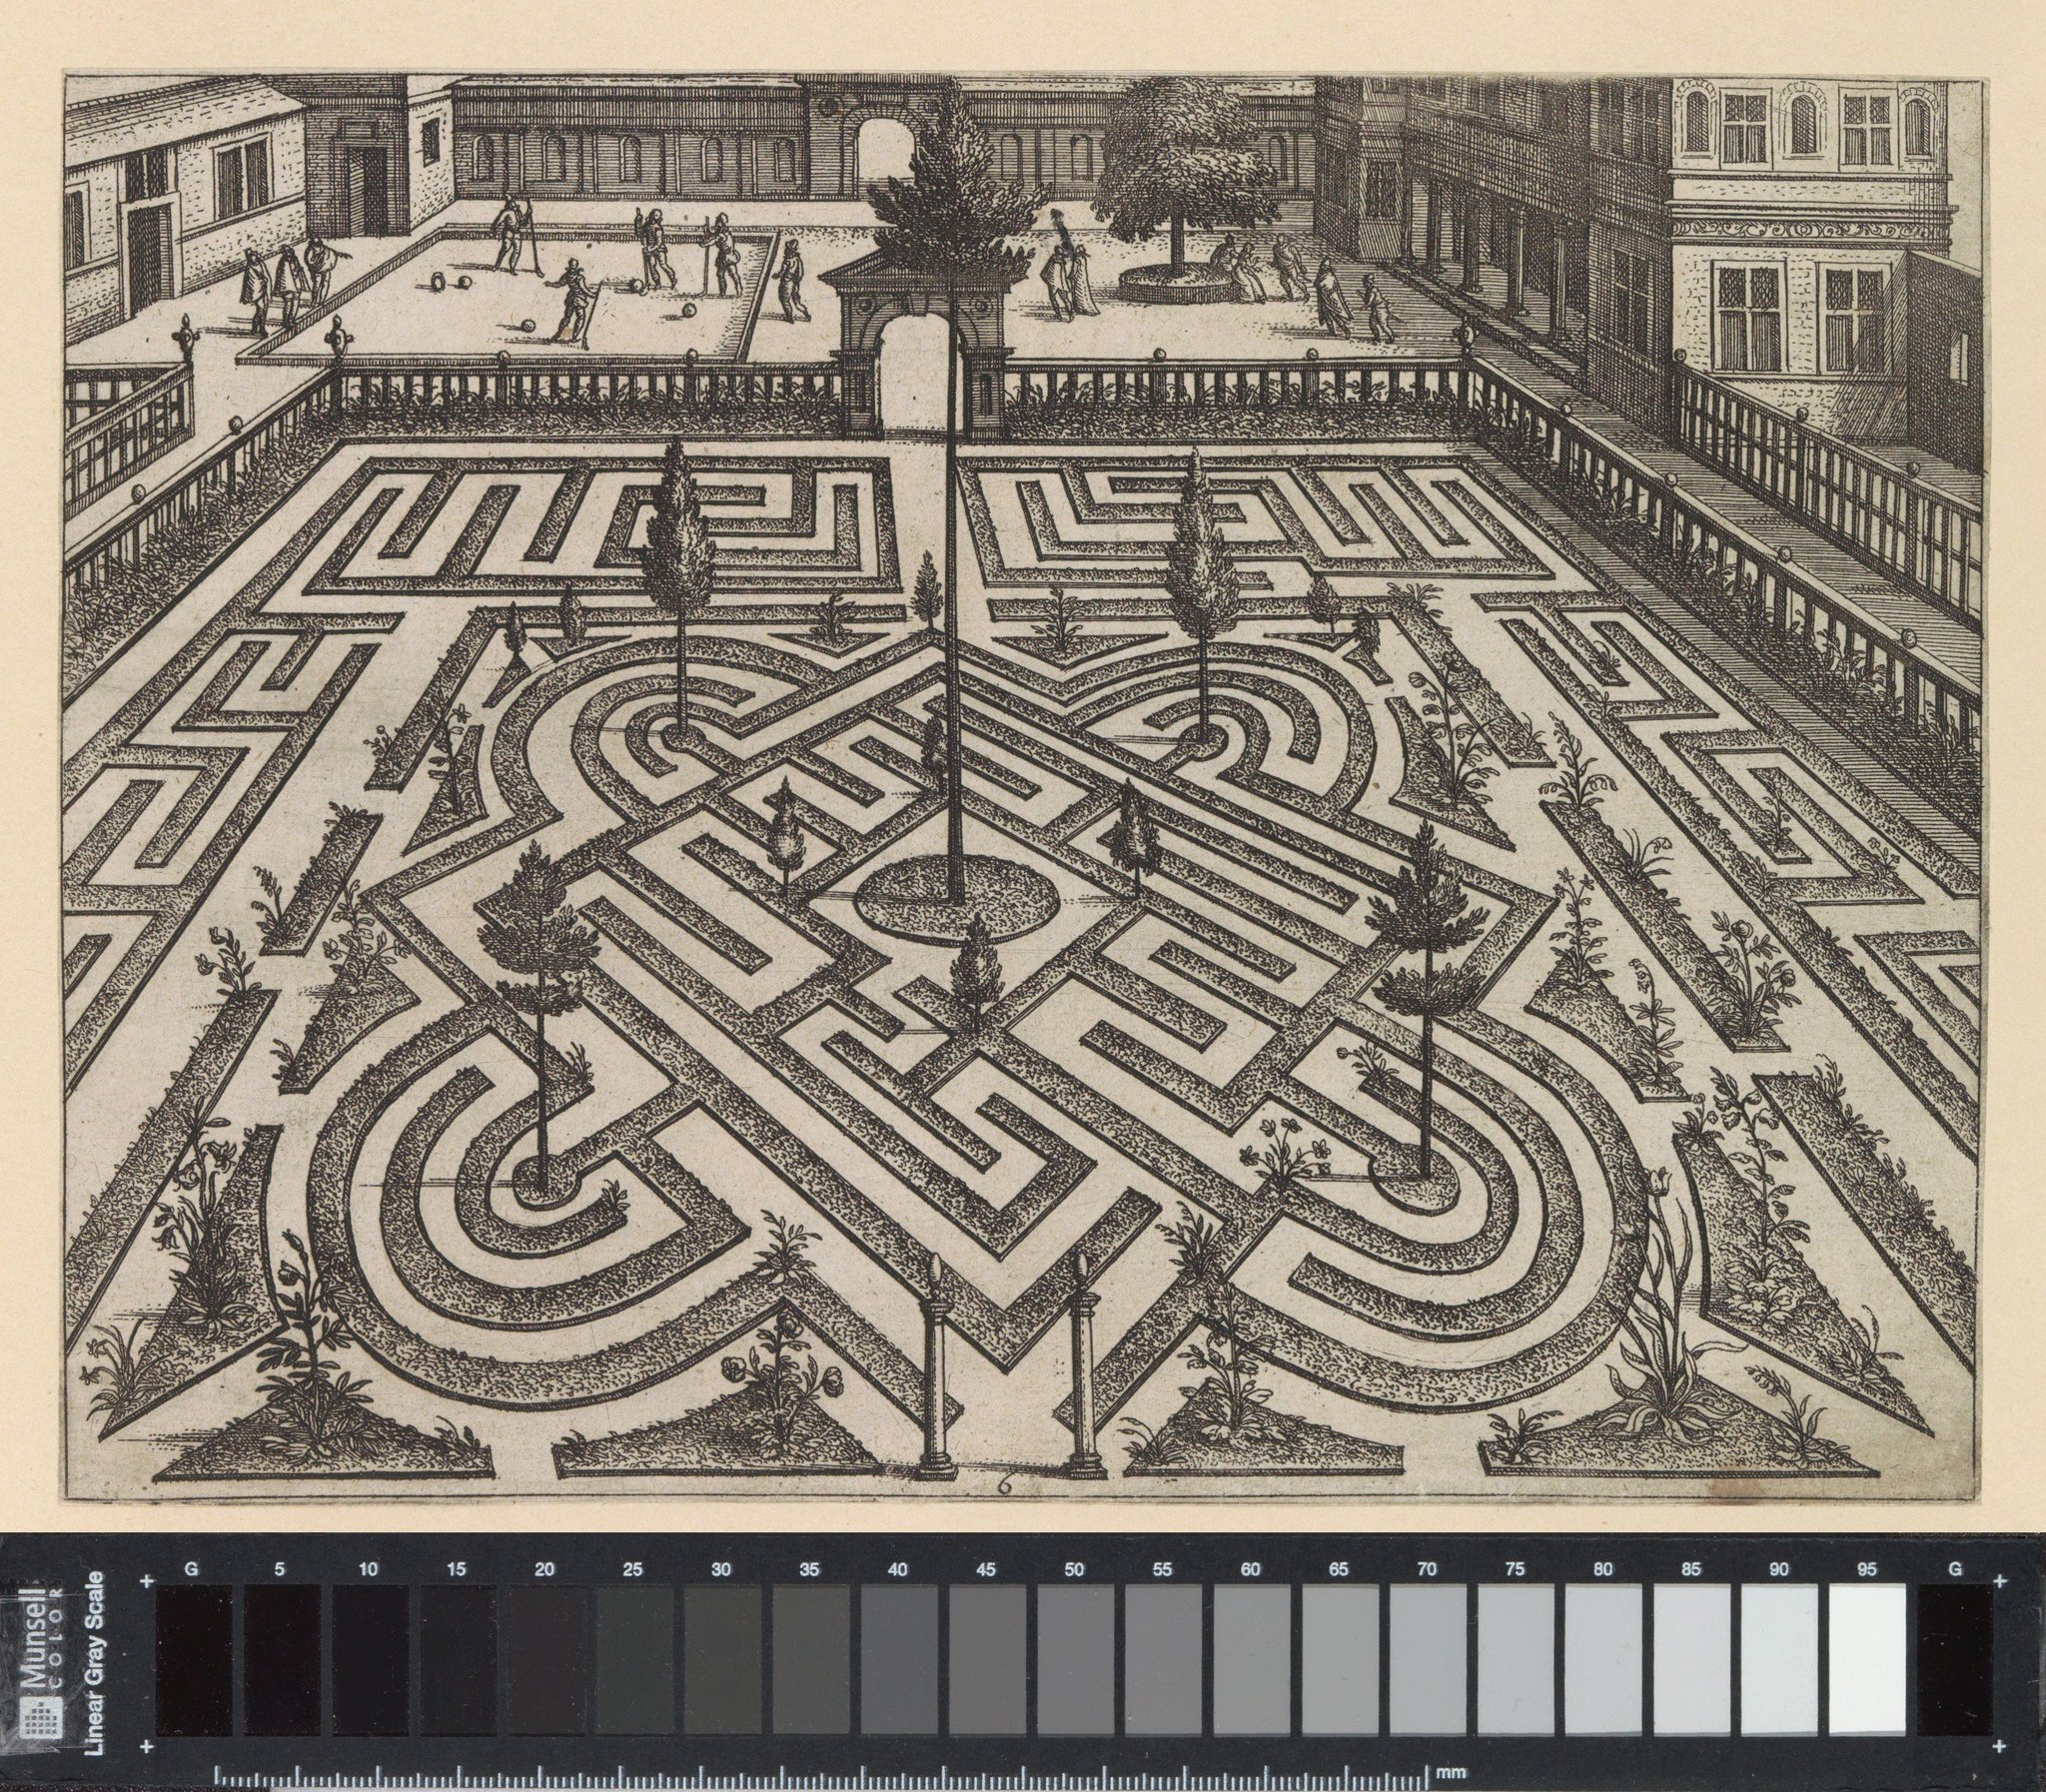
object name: ornament print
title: Hortorum Viridariorumque elegantes et multiplicis formae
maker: Anonymous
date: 1587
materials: paper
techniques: etching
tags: garden, labyrinth, maze ~ garden, 'kolf' (ball game)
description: Tuin met een parterre gevormd door lage perkjes in een geometrisch patroon, bestaande uit een ruit met halfronde uitstulpingen op de rechte zijden. Op de achtergrond ligt een plein waarop mensen kolf spelen. De prent maakt deel uit van een album.